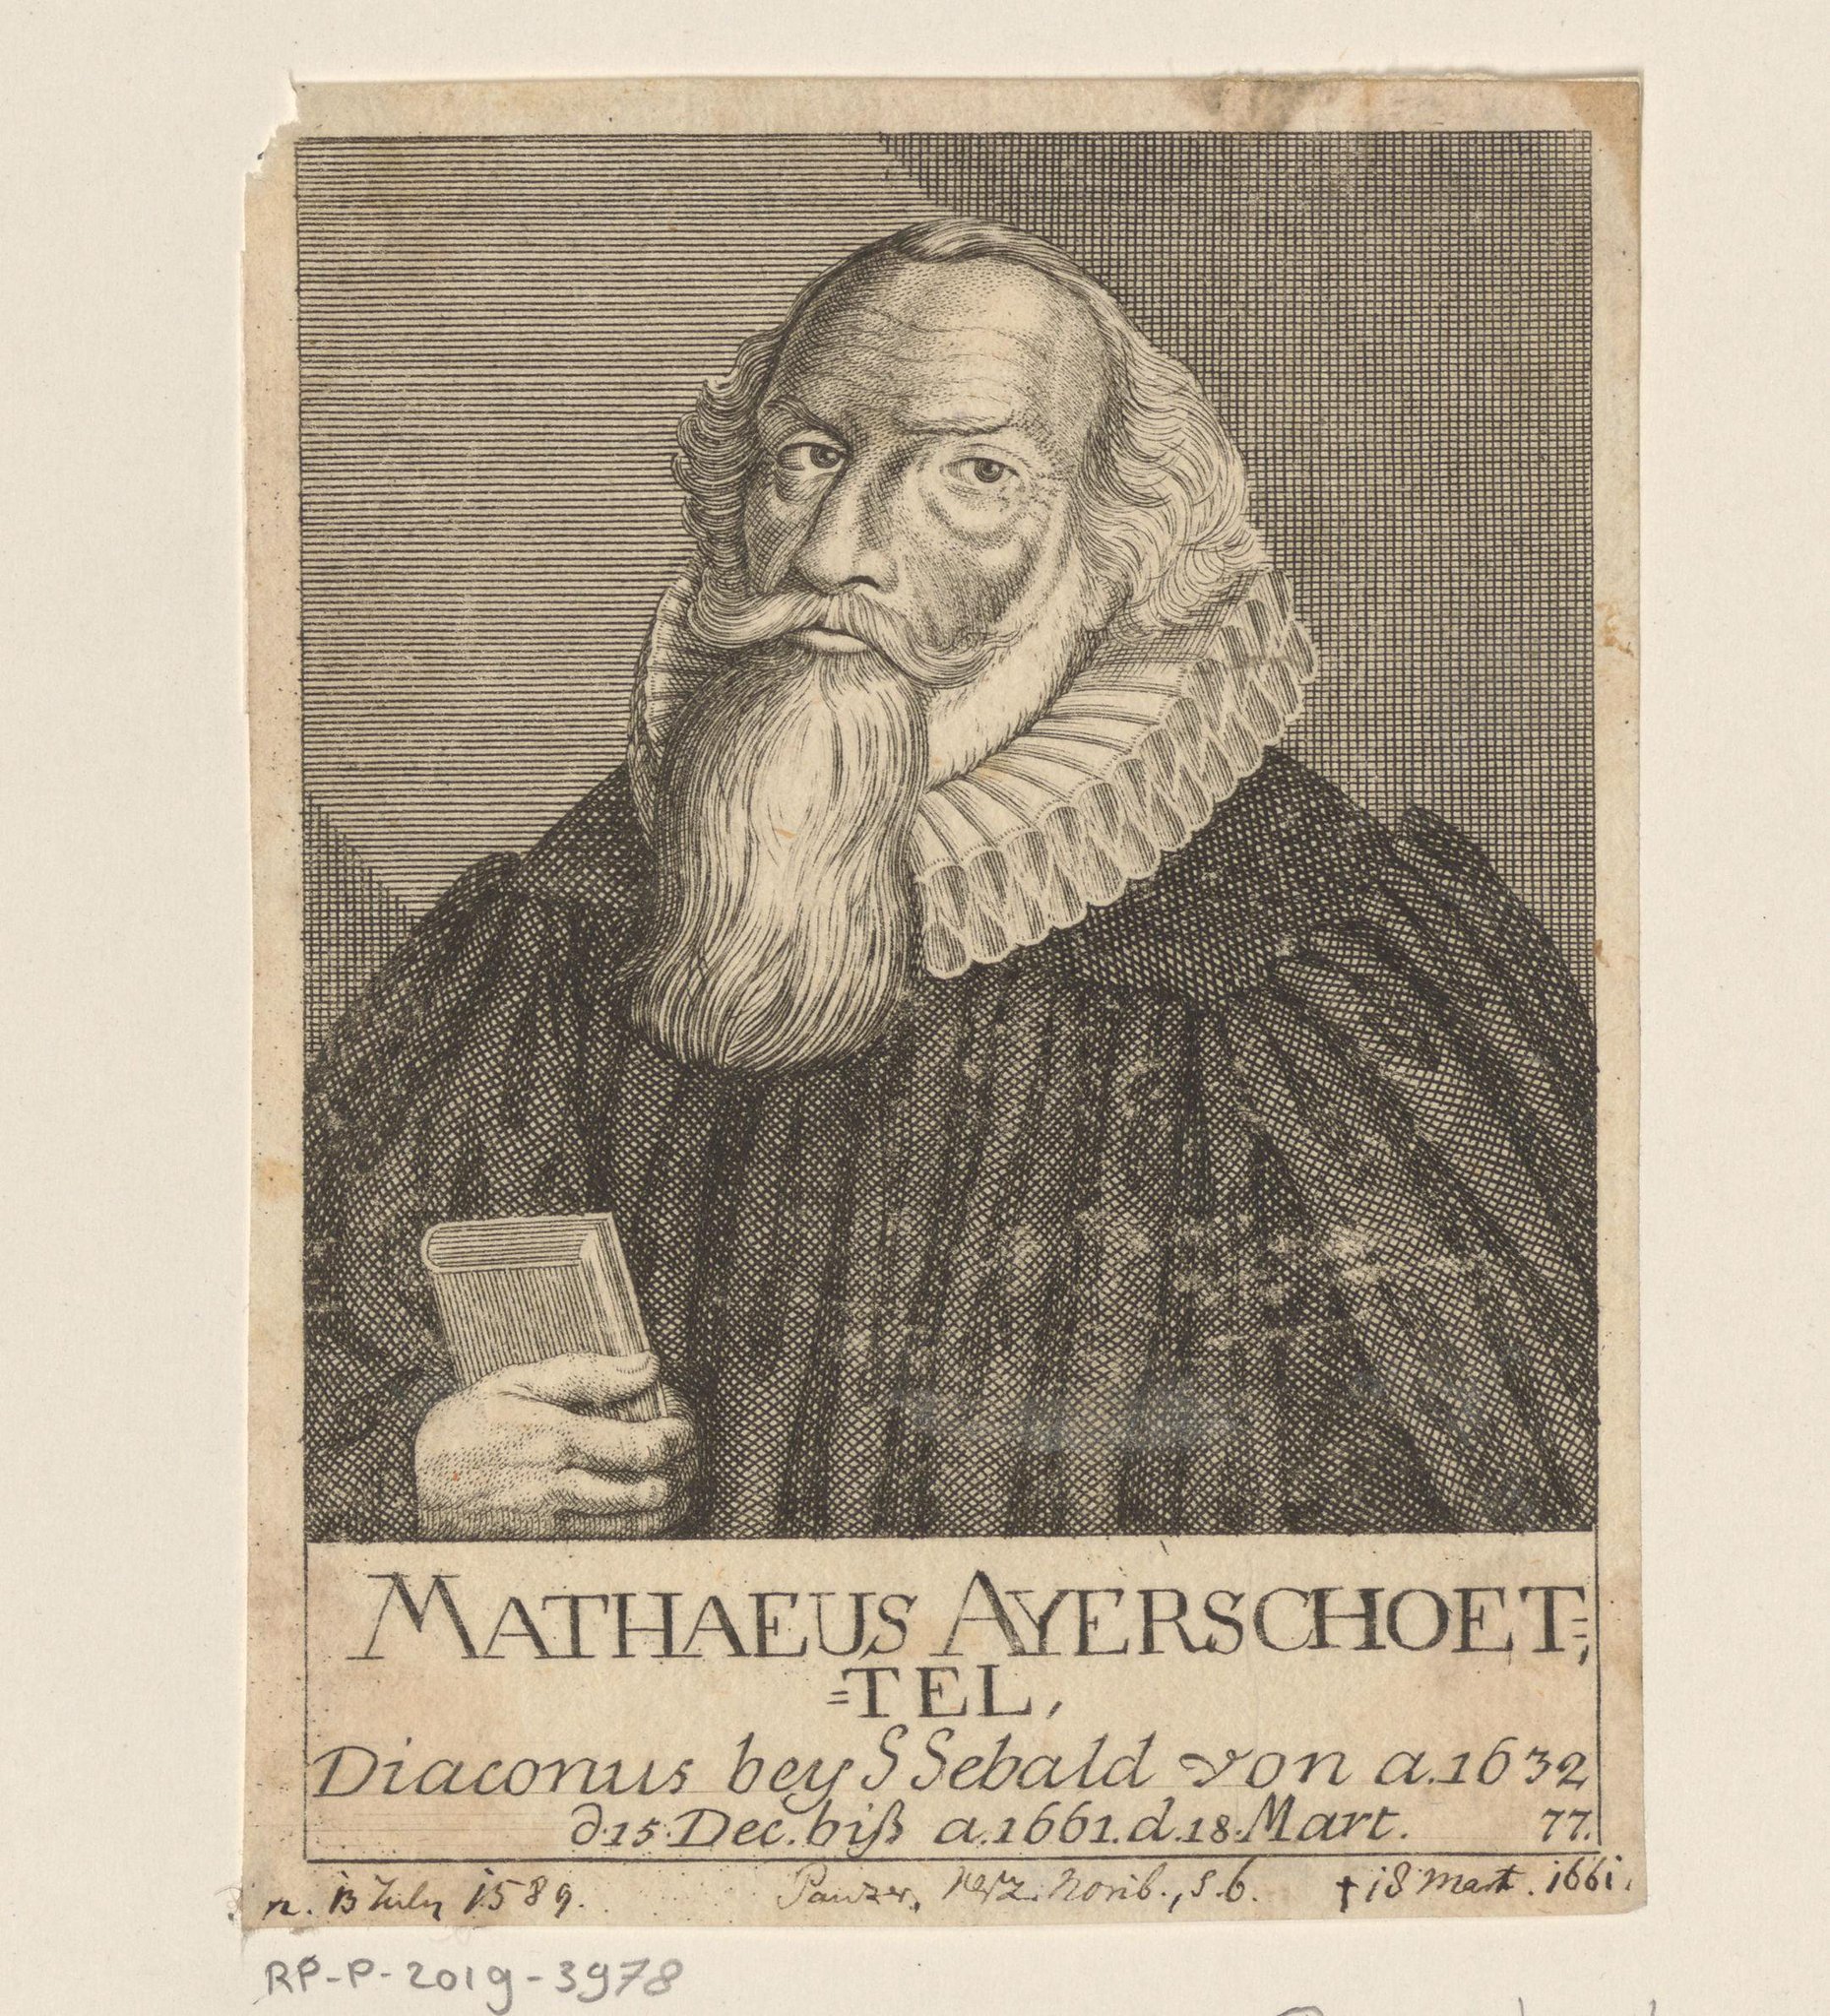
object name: print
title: Portret van Matthäus Ayerschöttel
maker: Anonymous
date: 1756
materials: paper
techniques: engraving, etching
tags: theologian, historical persons, book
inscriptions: inscription: ‘n. B July 1589 [...]’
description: Prent uit: Würfel, Andreas. Diptycha ecclesiae Sebaldianae (...). Neurenberg: s.n., 1756.